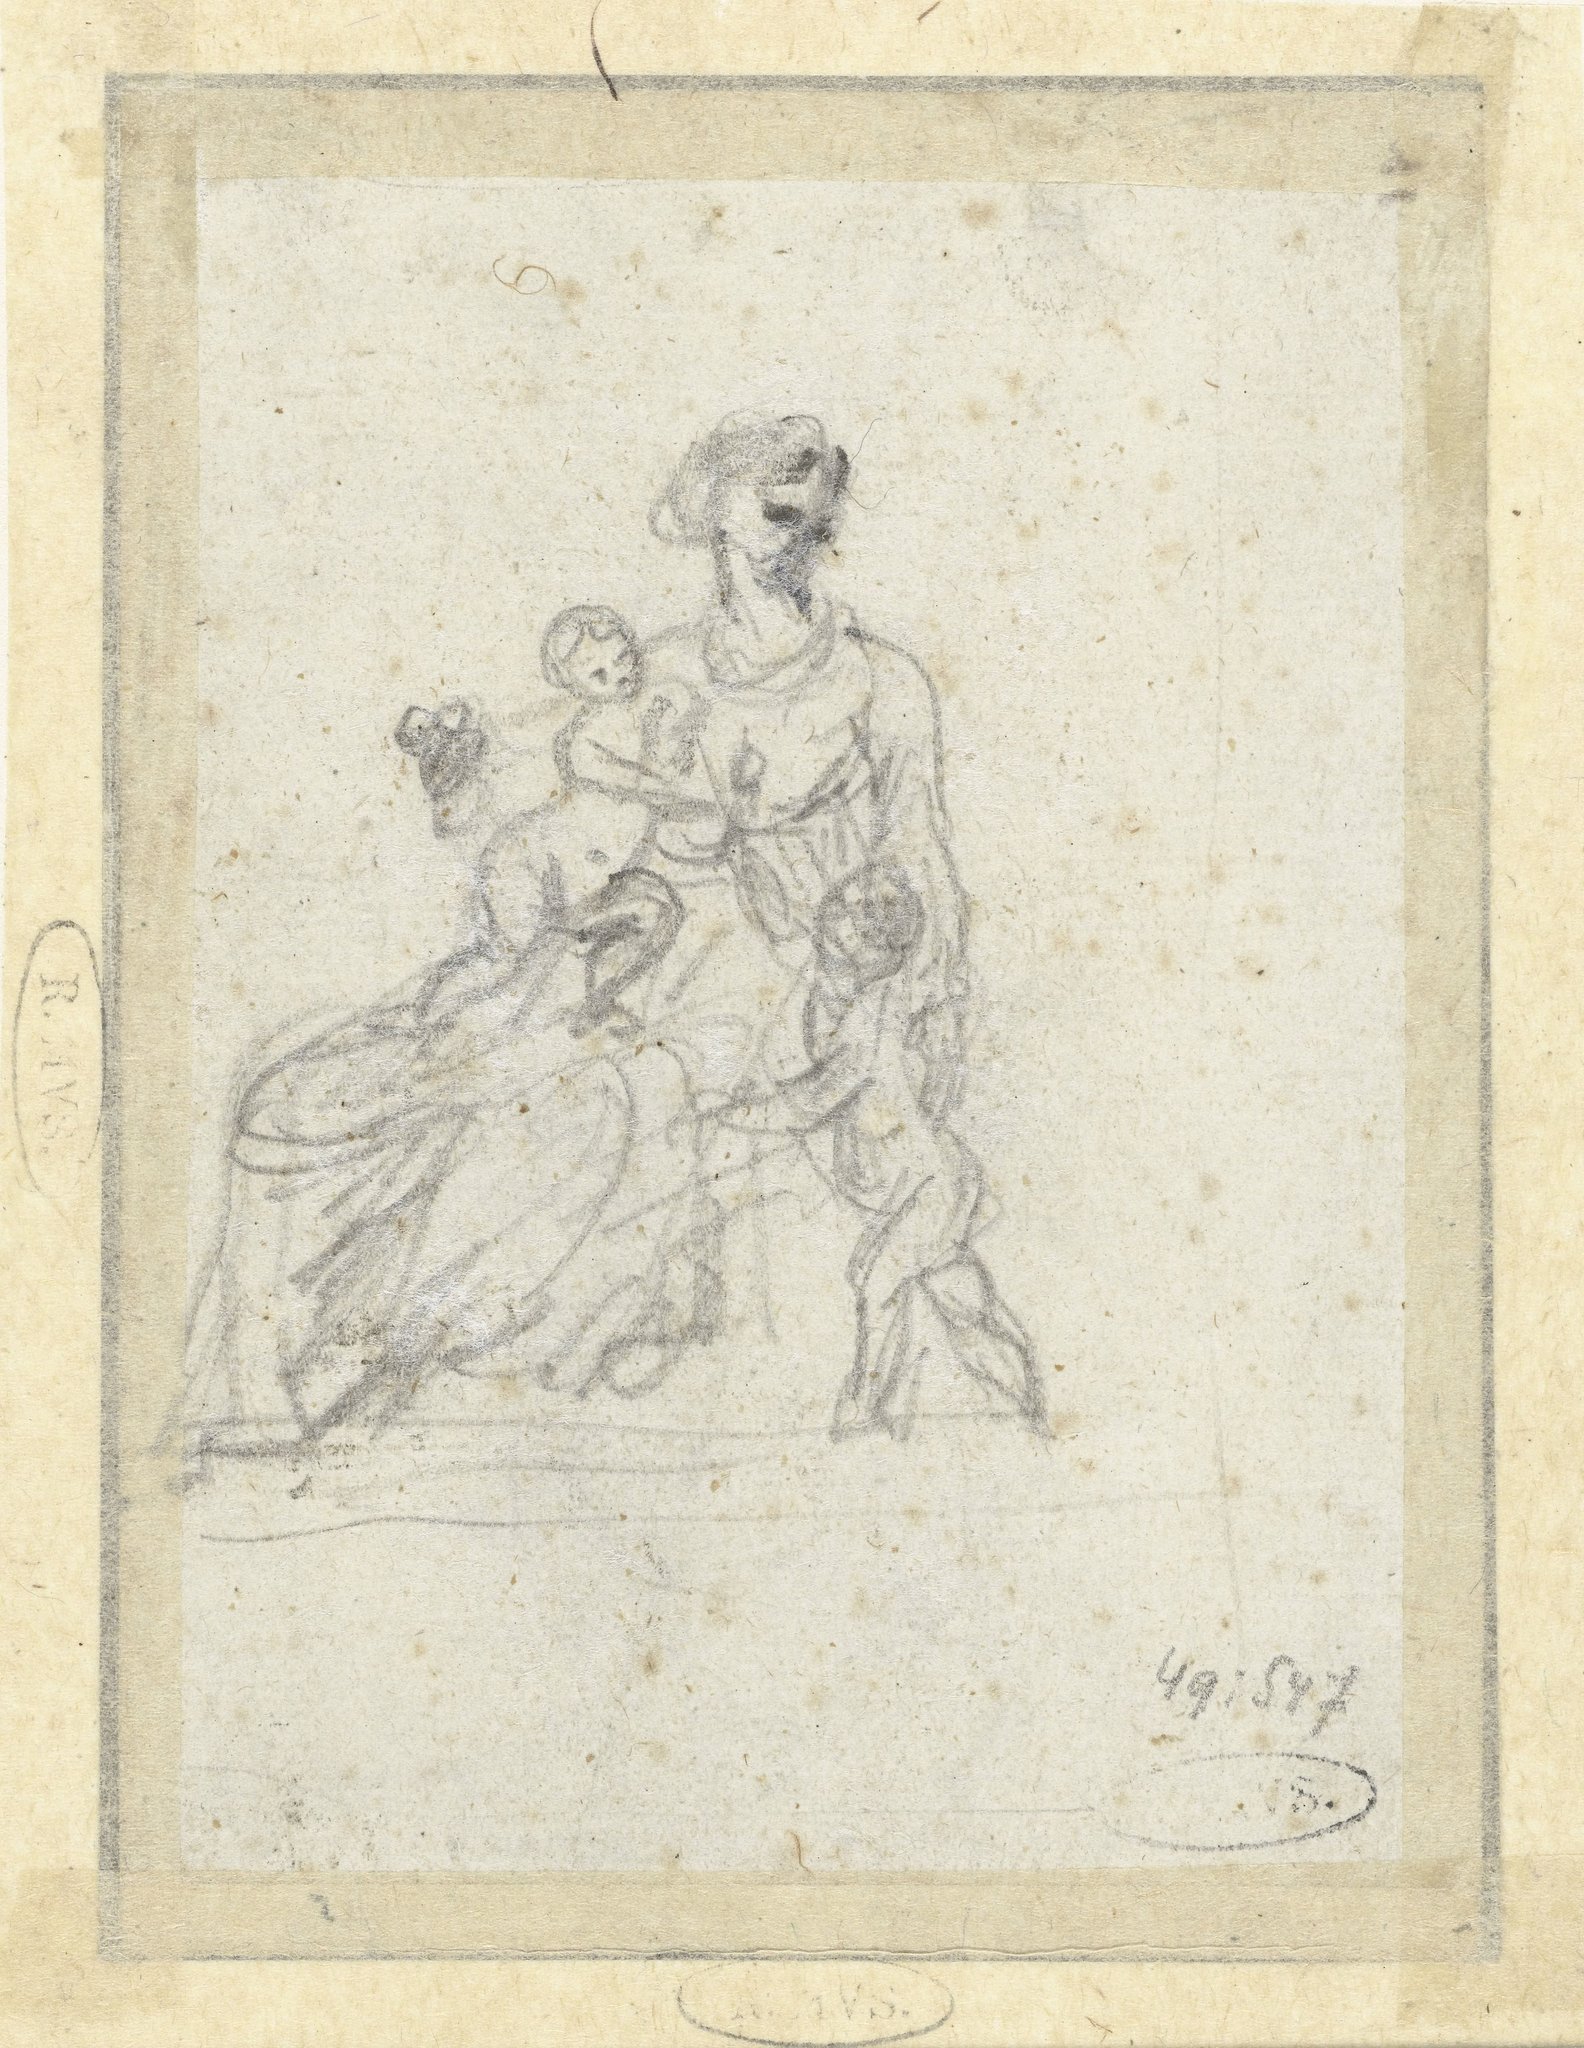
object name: drawing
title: Maria met kind en H. Johannes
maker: claude lorrain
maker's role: draughtsman, print maker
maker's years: 1604-1682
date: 1635-1645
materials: chalk, paper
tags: john the baptist as child ~ madonna-representations (n.b. secondary notation only), madonna (i.e. mary with the christ-child) accompanied or surrounded by others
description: Bladen van serie zijn afkomstig uit een schetsboek.